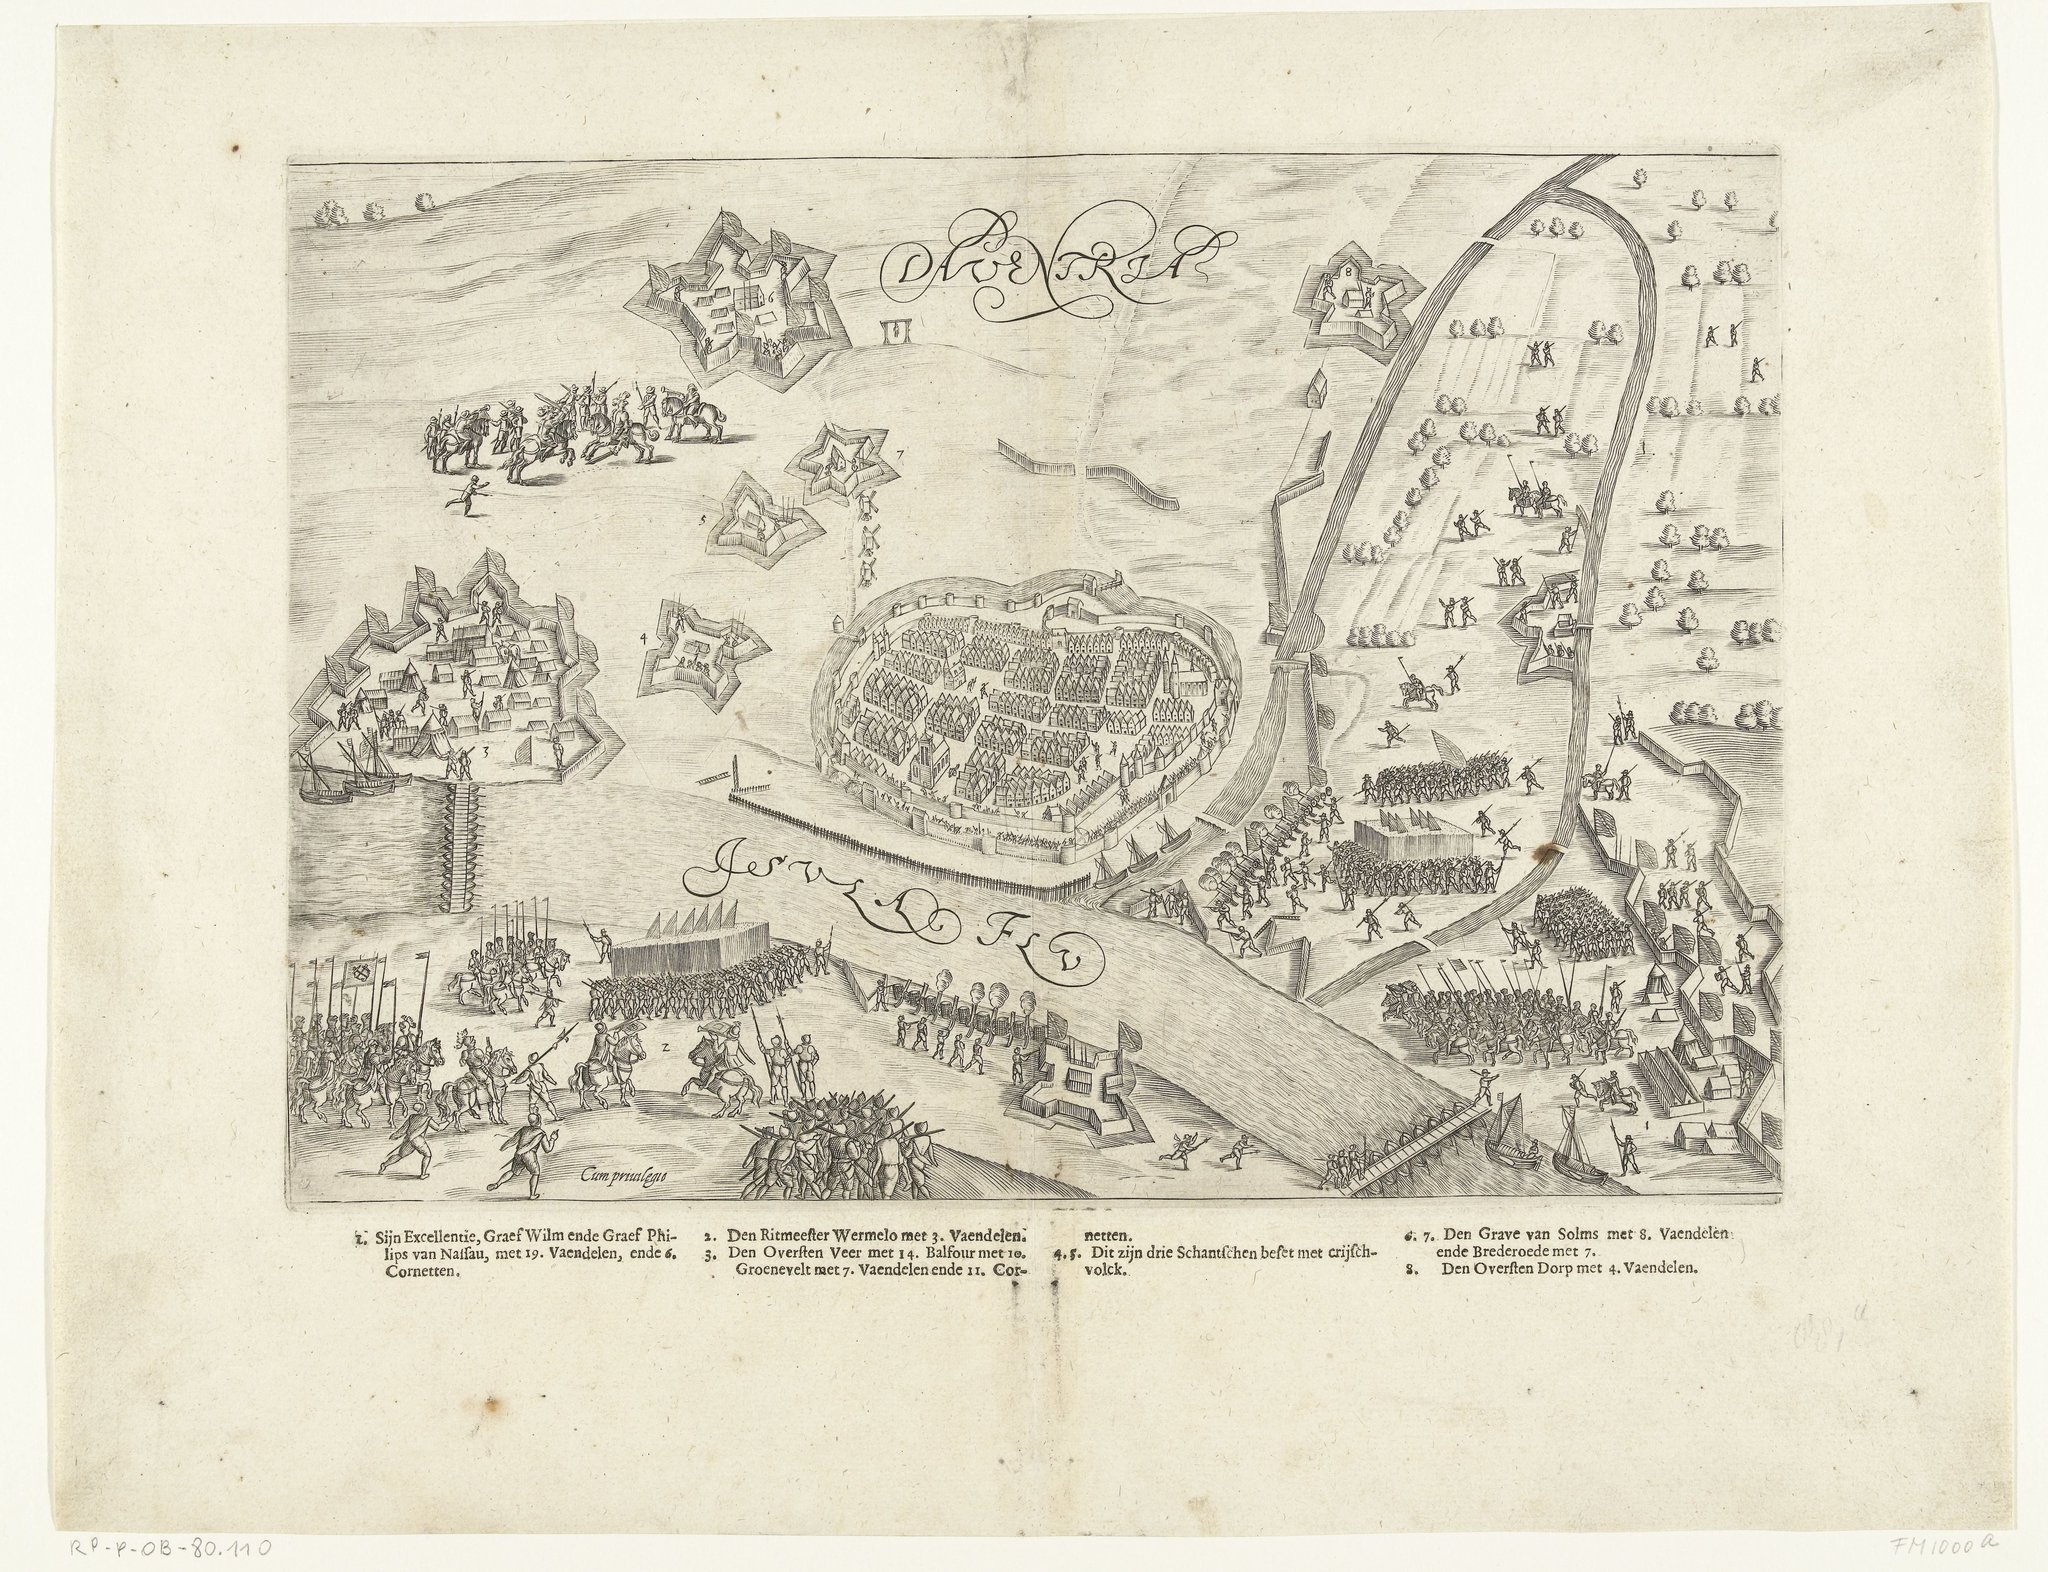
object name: print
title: Beleg en inname van Deventer, 1591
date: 1600-1601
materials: paper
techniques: engraving, letterpress printing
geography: northern netherlands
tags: improvised bridge, temporary bridge ~ military engineering, capture of city (after the siege), deventer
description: Gebruikt als illustratie in: J.J. Orlers, Den Nassauschen Lauren-Crans: Beschrijvinghe ende af-beeldinge van alle de victorien ... die Godt Almachtich de ... Staten der Vereenichde Nederlanden verleent heeft, deur het wijs ende clouck beleyt des Hooch-ghebooren Fursts Maurits van Nassau, J.J. Orlers en H. van Haestens, Leiden 1610, fol. 80/81.